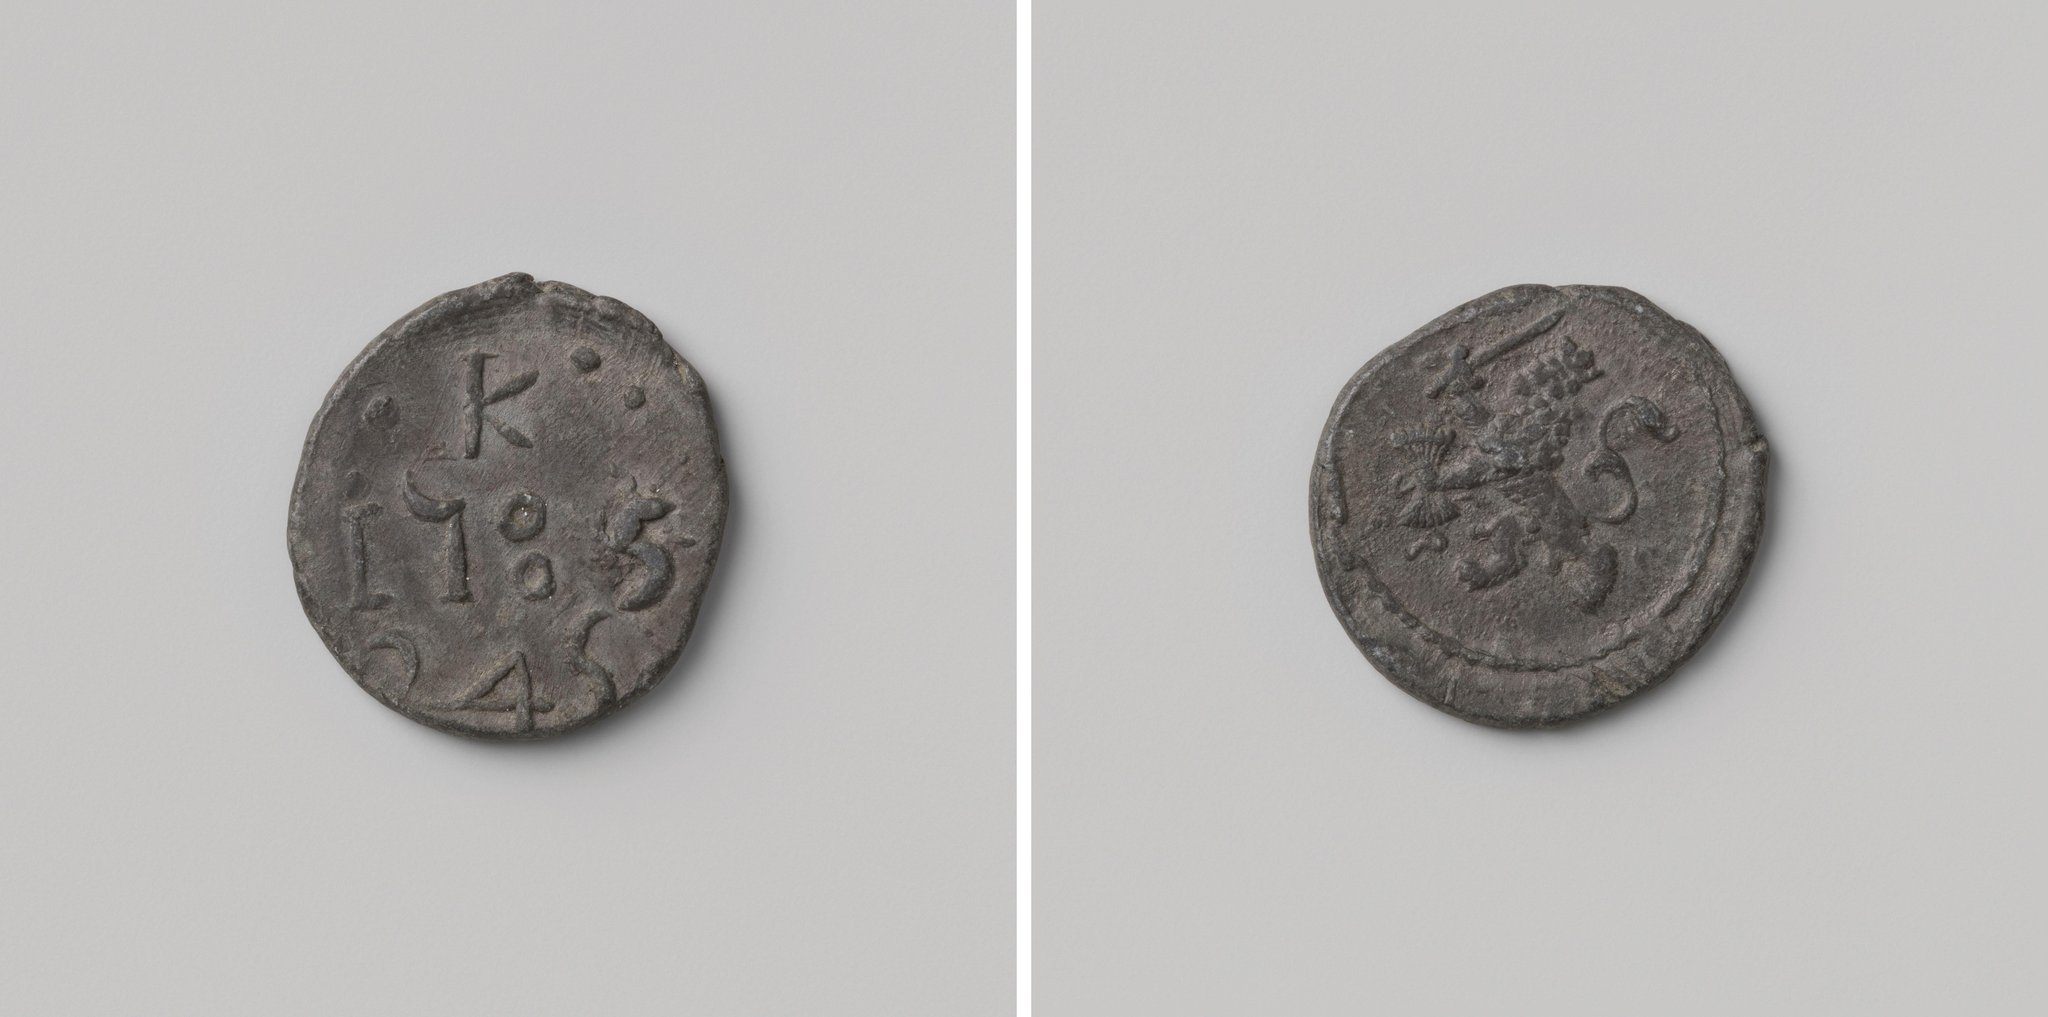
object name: tax token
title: Loden penning voor de Kille (Dordtse Kil) met K 1785 24 S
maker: Anonymous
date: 1785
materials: lead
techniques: striking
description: Voorzijde: opschrift K 1785 24s. Keerzijde: gekroonde leeuw met zwaard en pijlenbundel